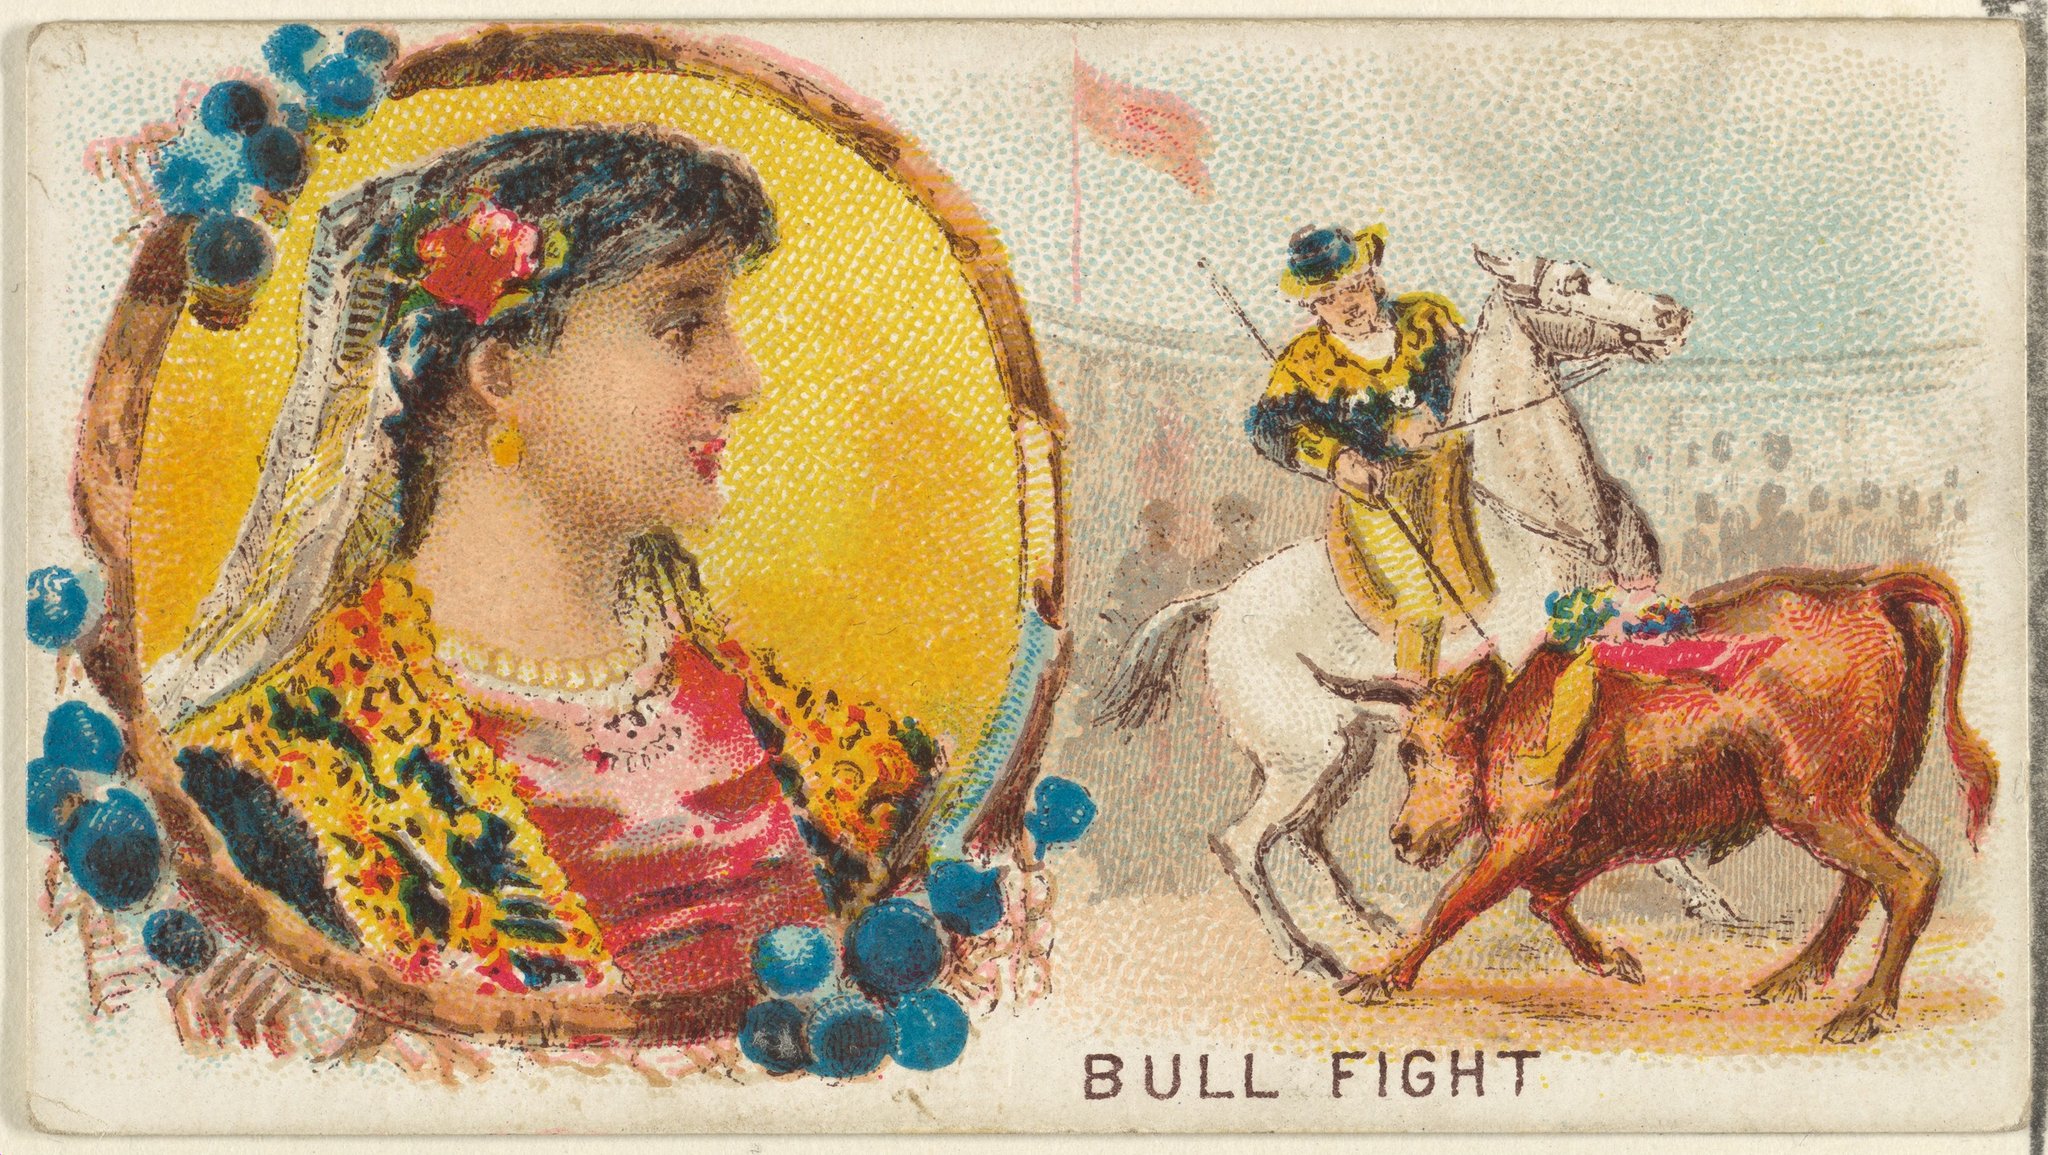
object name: print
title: Bull Fight, from the Games and Sports series (N165) for Old Judge Cigarettes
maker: goodwin & company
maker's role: publisher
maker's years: 1850-1950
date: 1889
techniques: color lithograph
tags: men,women,bulls,horses